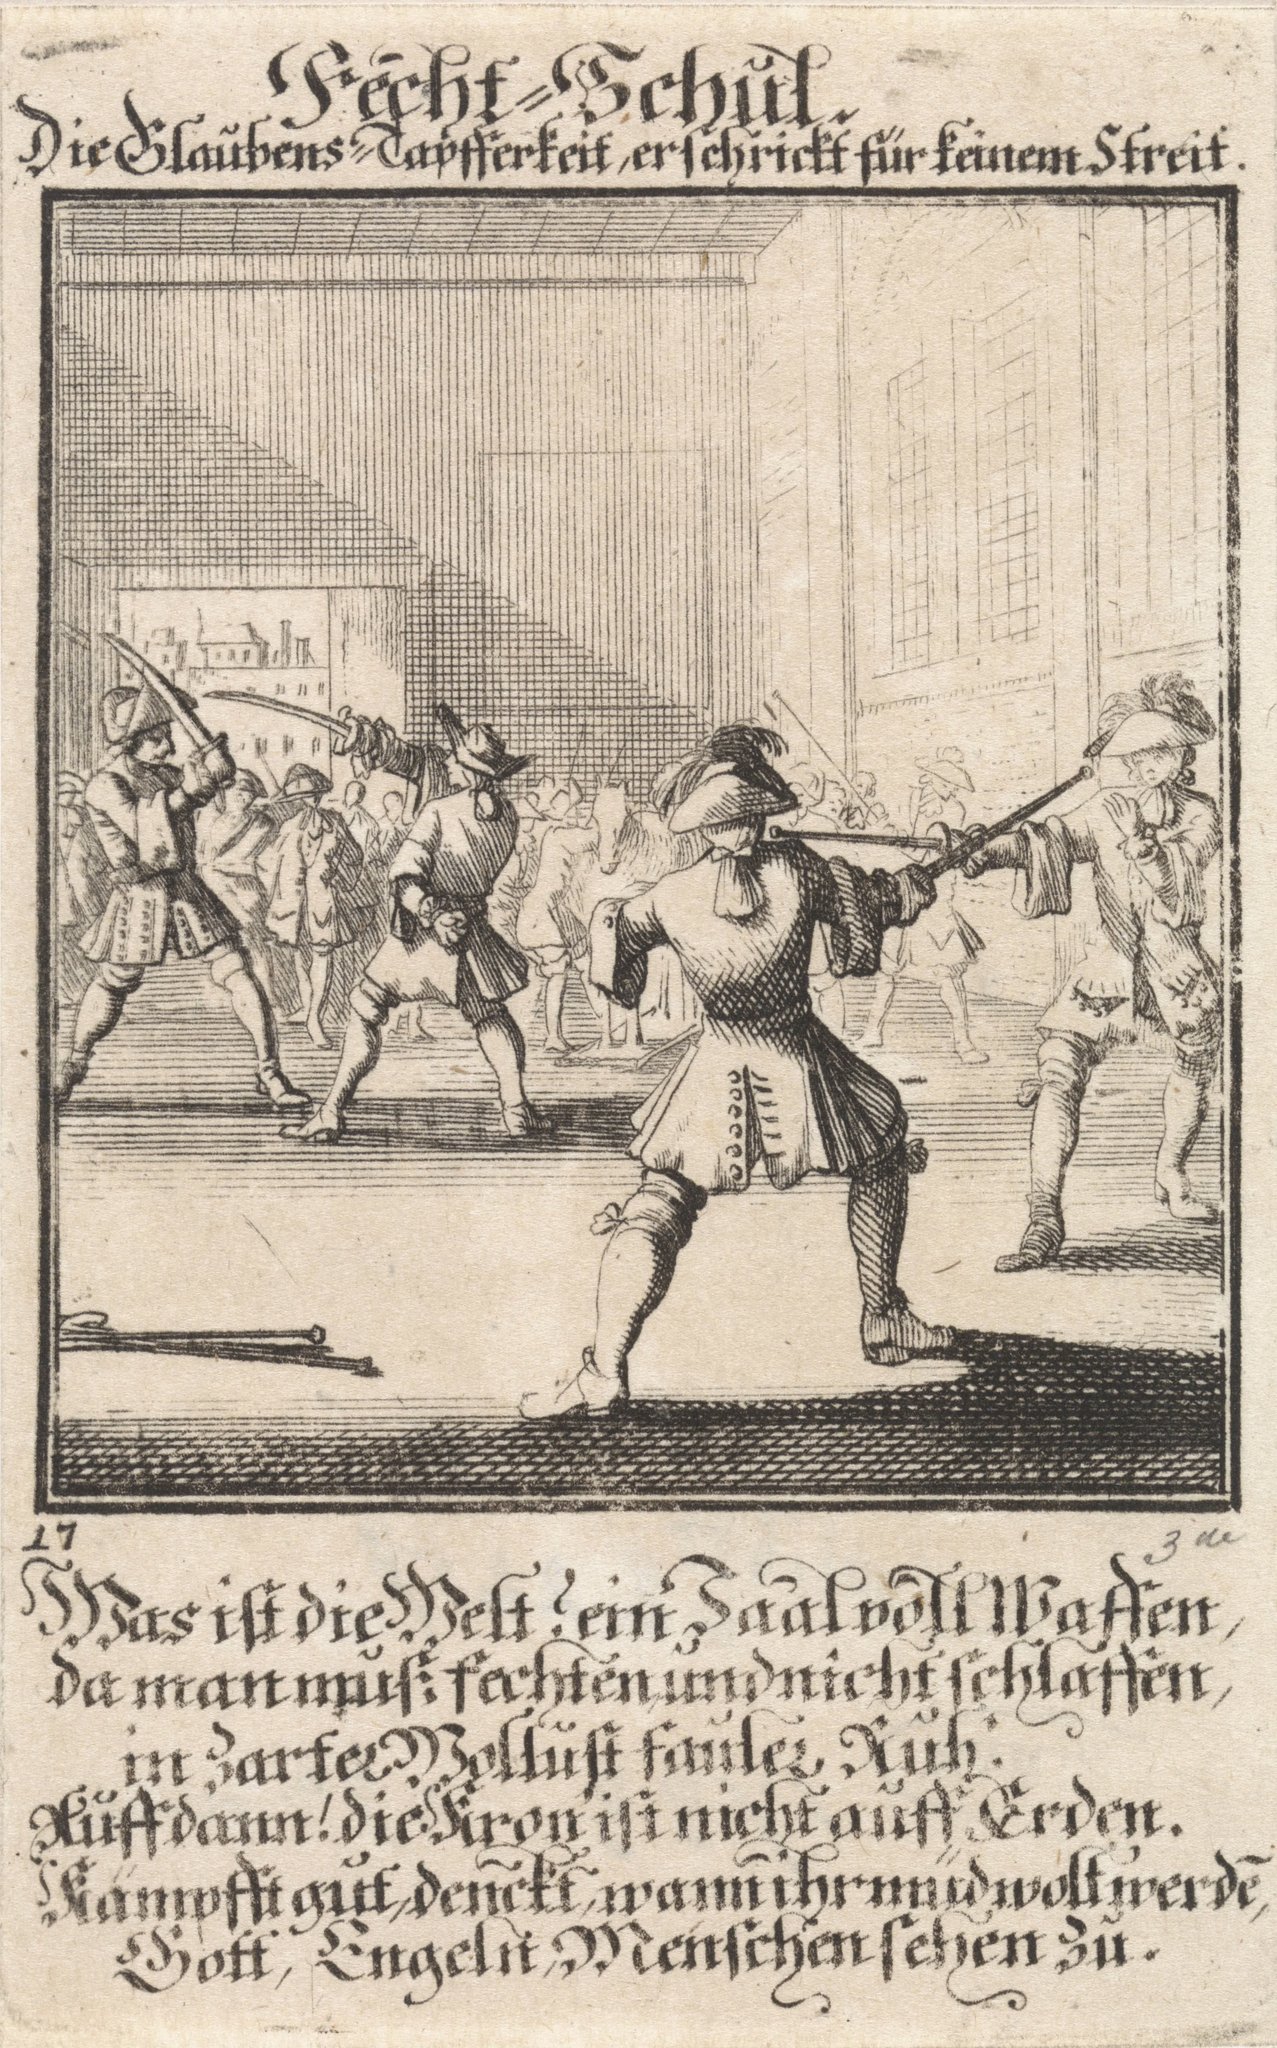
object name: book illustration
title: Schermschool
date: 1711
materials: paper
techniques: etching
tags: sabre (~ fencing)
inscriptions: collector's mark: Lugt 2228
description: Illustratie uit: Sancta Clara, Abraham à. Etwas für Alle, das ist: Eine kurtze Beschreibung allerley Stands- Ambts- und Gewerbs-Persohnen (...), 3 delen (1699-1733). Würtzburg: Martin Frantz Hertz, 1711, dl. III, p. 155. Het betreft hier de tweede druk van deel III.